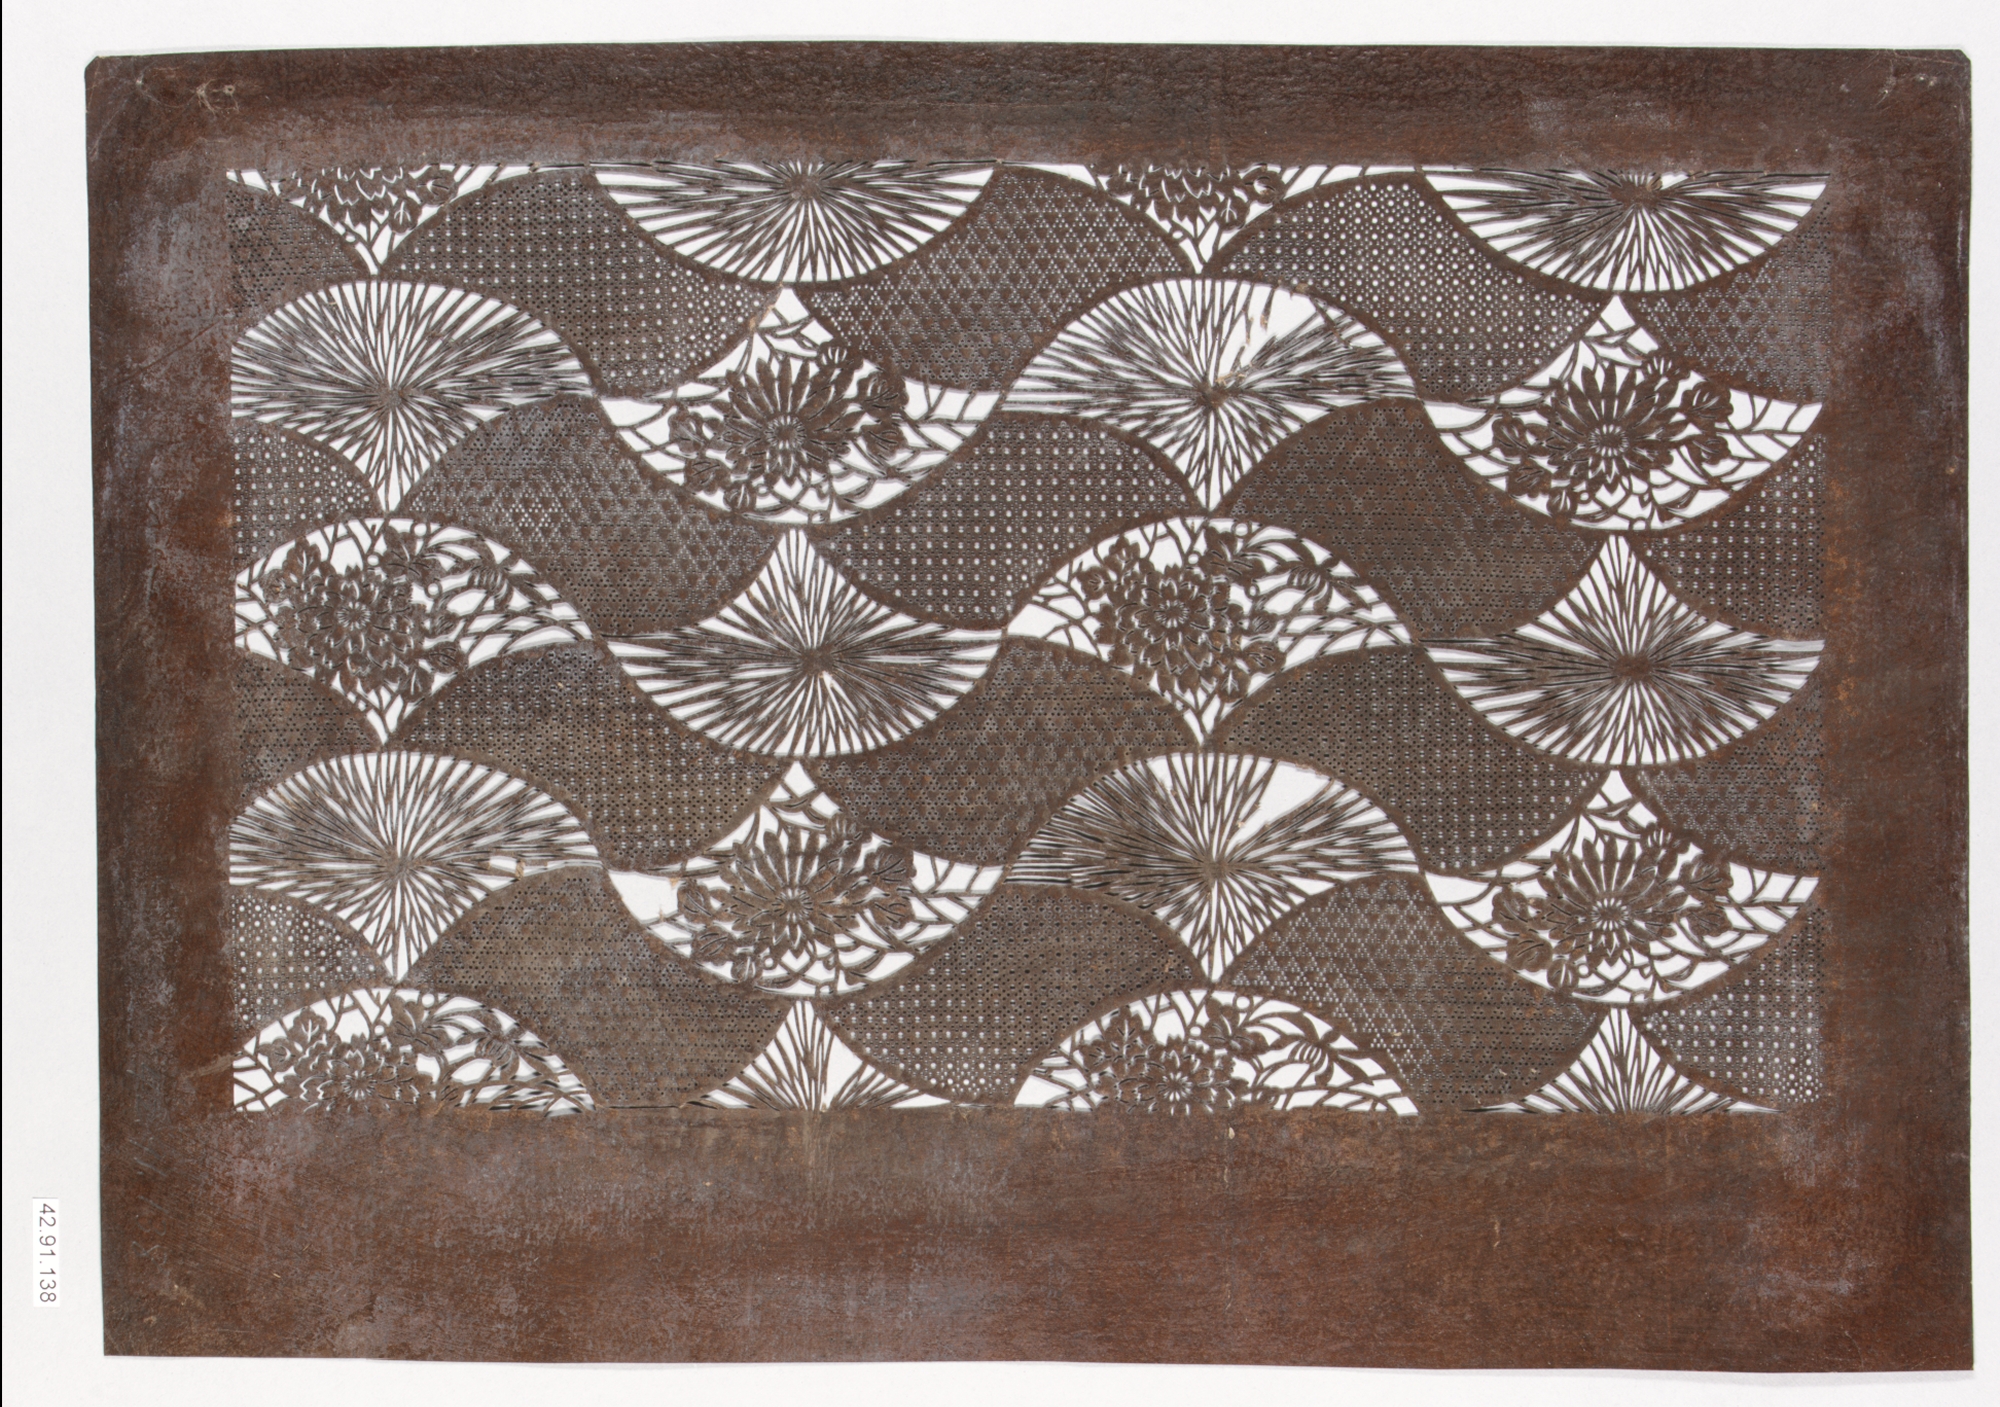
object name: stencil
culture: japanese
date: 1801-1900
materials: paper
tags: flowers